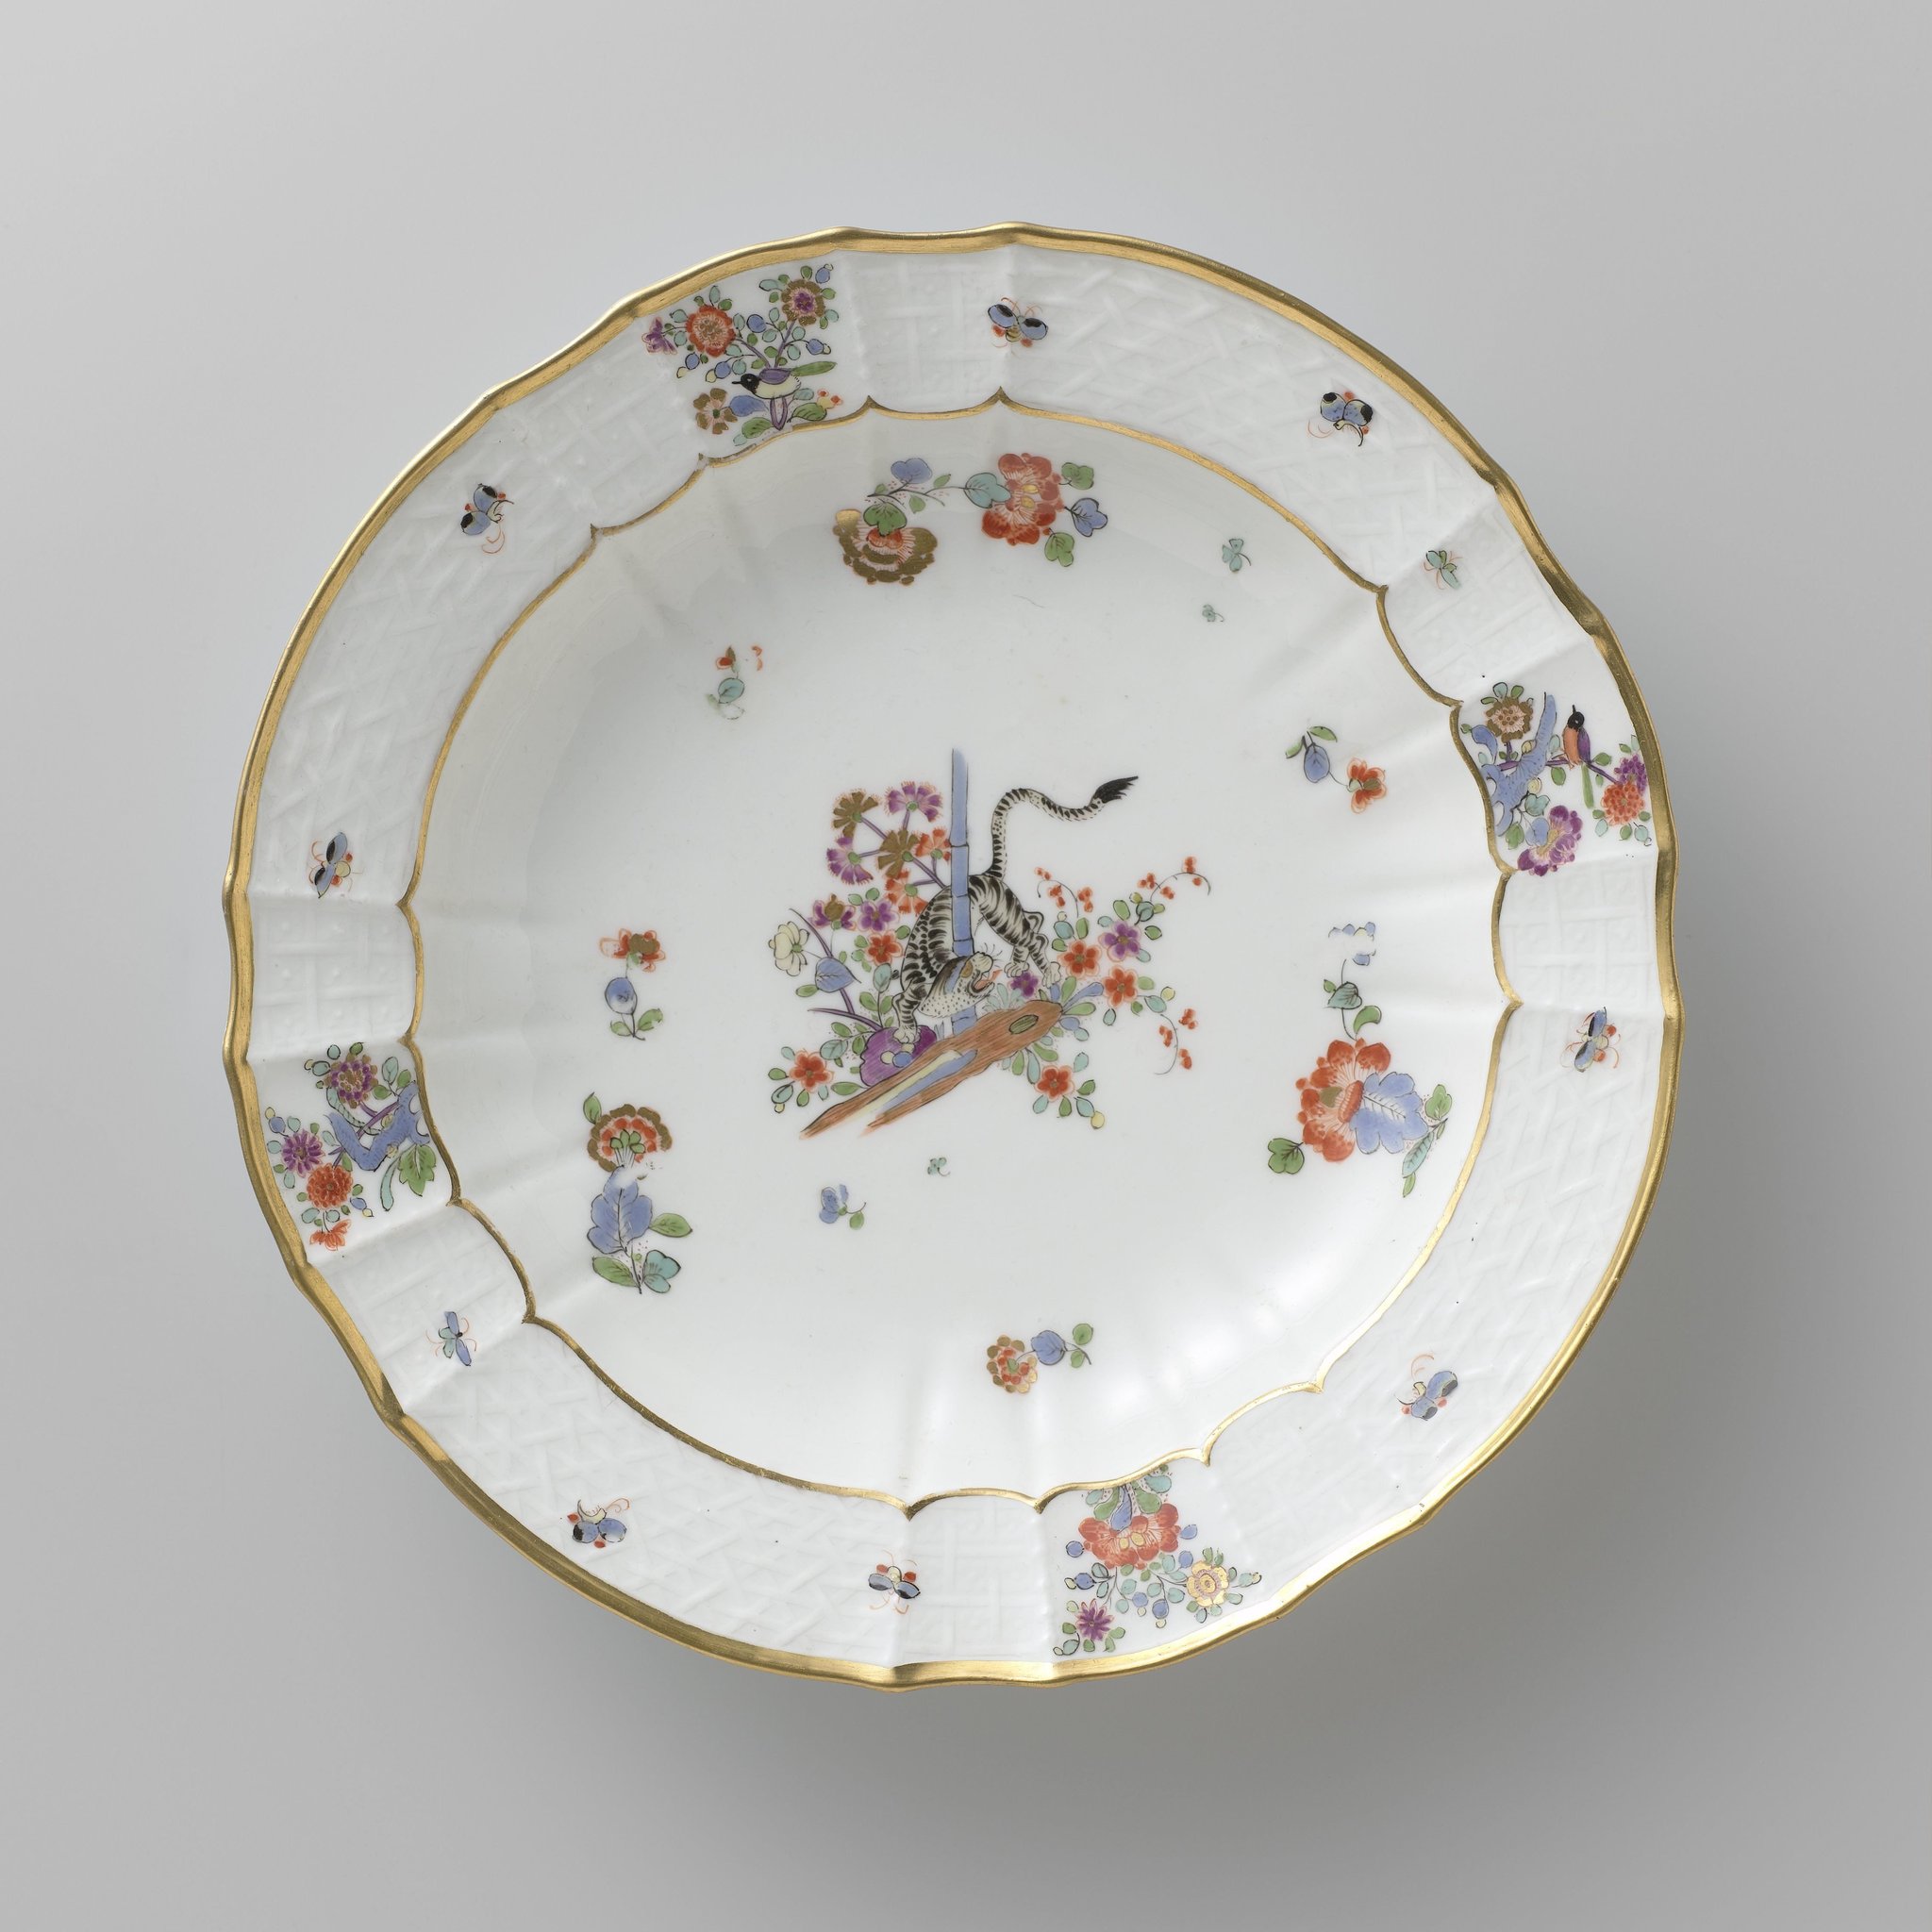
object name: eating drinking utensil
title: Soepbord, veelkleurig beschilderd met een Kakiemon-decor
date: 1740-1745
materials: porcelain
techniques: painted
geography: meissen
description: Soepbord van beschilderd porselein. Het bord heeft een geribde en geschulpte rand. Het bord is beschilderd met een tijger, die zich tussen bloemen om een bamboestengel draait, gestrooide Indianische Blumen, vlinders en takken met vogels. De rand is versierd met het 'Altbrandenstein'-patroon. Het bord is gemerkt.